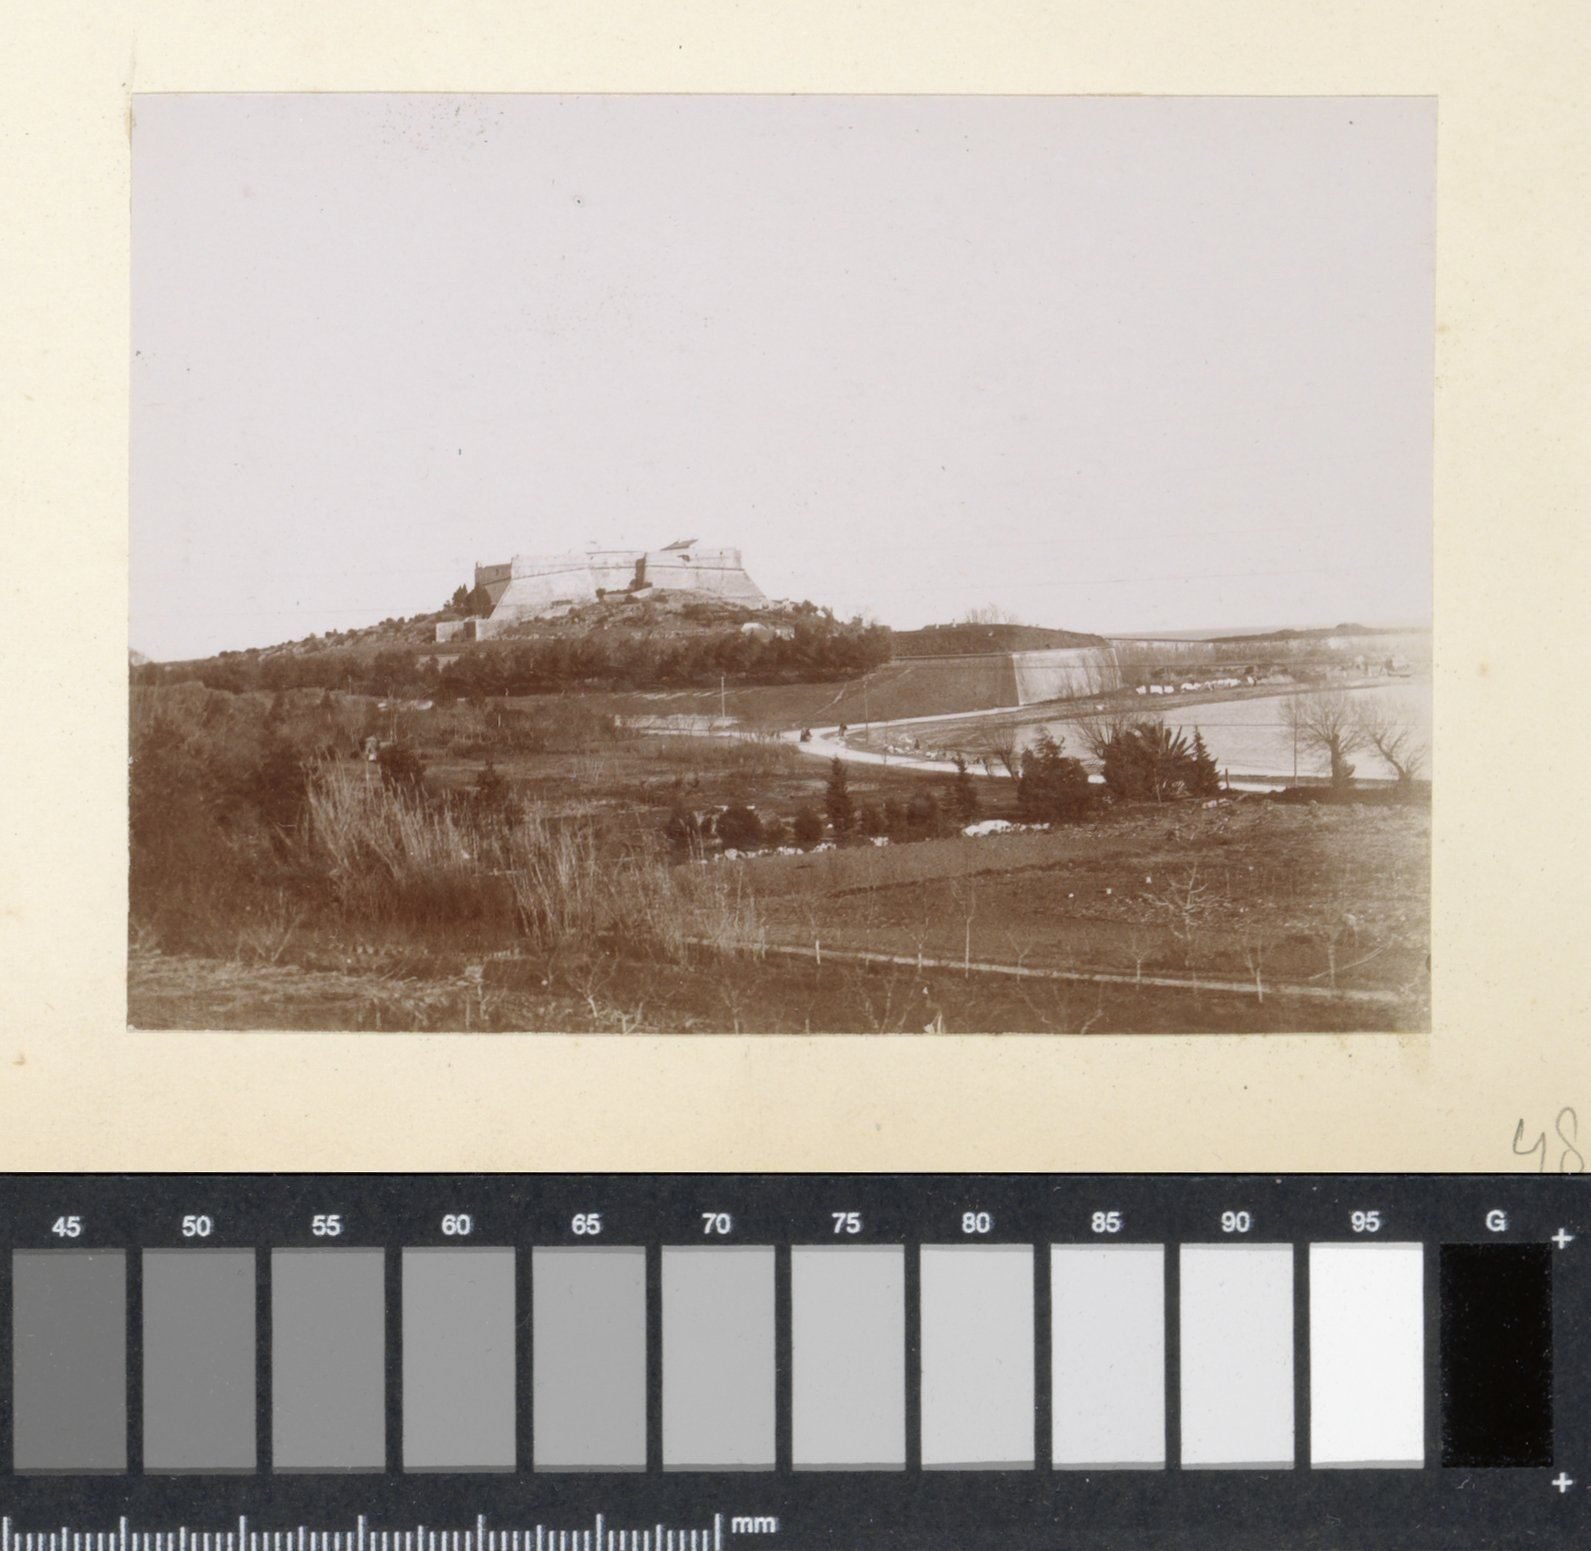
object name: photograph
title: Gezicht op een fort, vermoedelijk aan de kust van Zuid-Frankrijk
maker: Anonymous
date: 1900-1910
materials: paper, photographic support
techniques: daylight paper print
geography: southern france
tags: fortress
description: Onderdeel van Fotoalbum van een Franse amateurfotograaf met opnames van een familie, distilleerderij Delizy & Doistau Fils, het leger en bezienswaardigheden in Frankrijk.